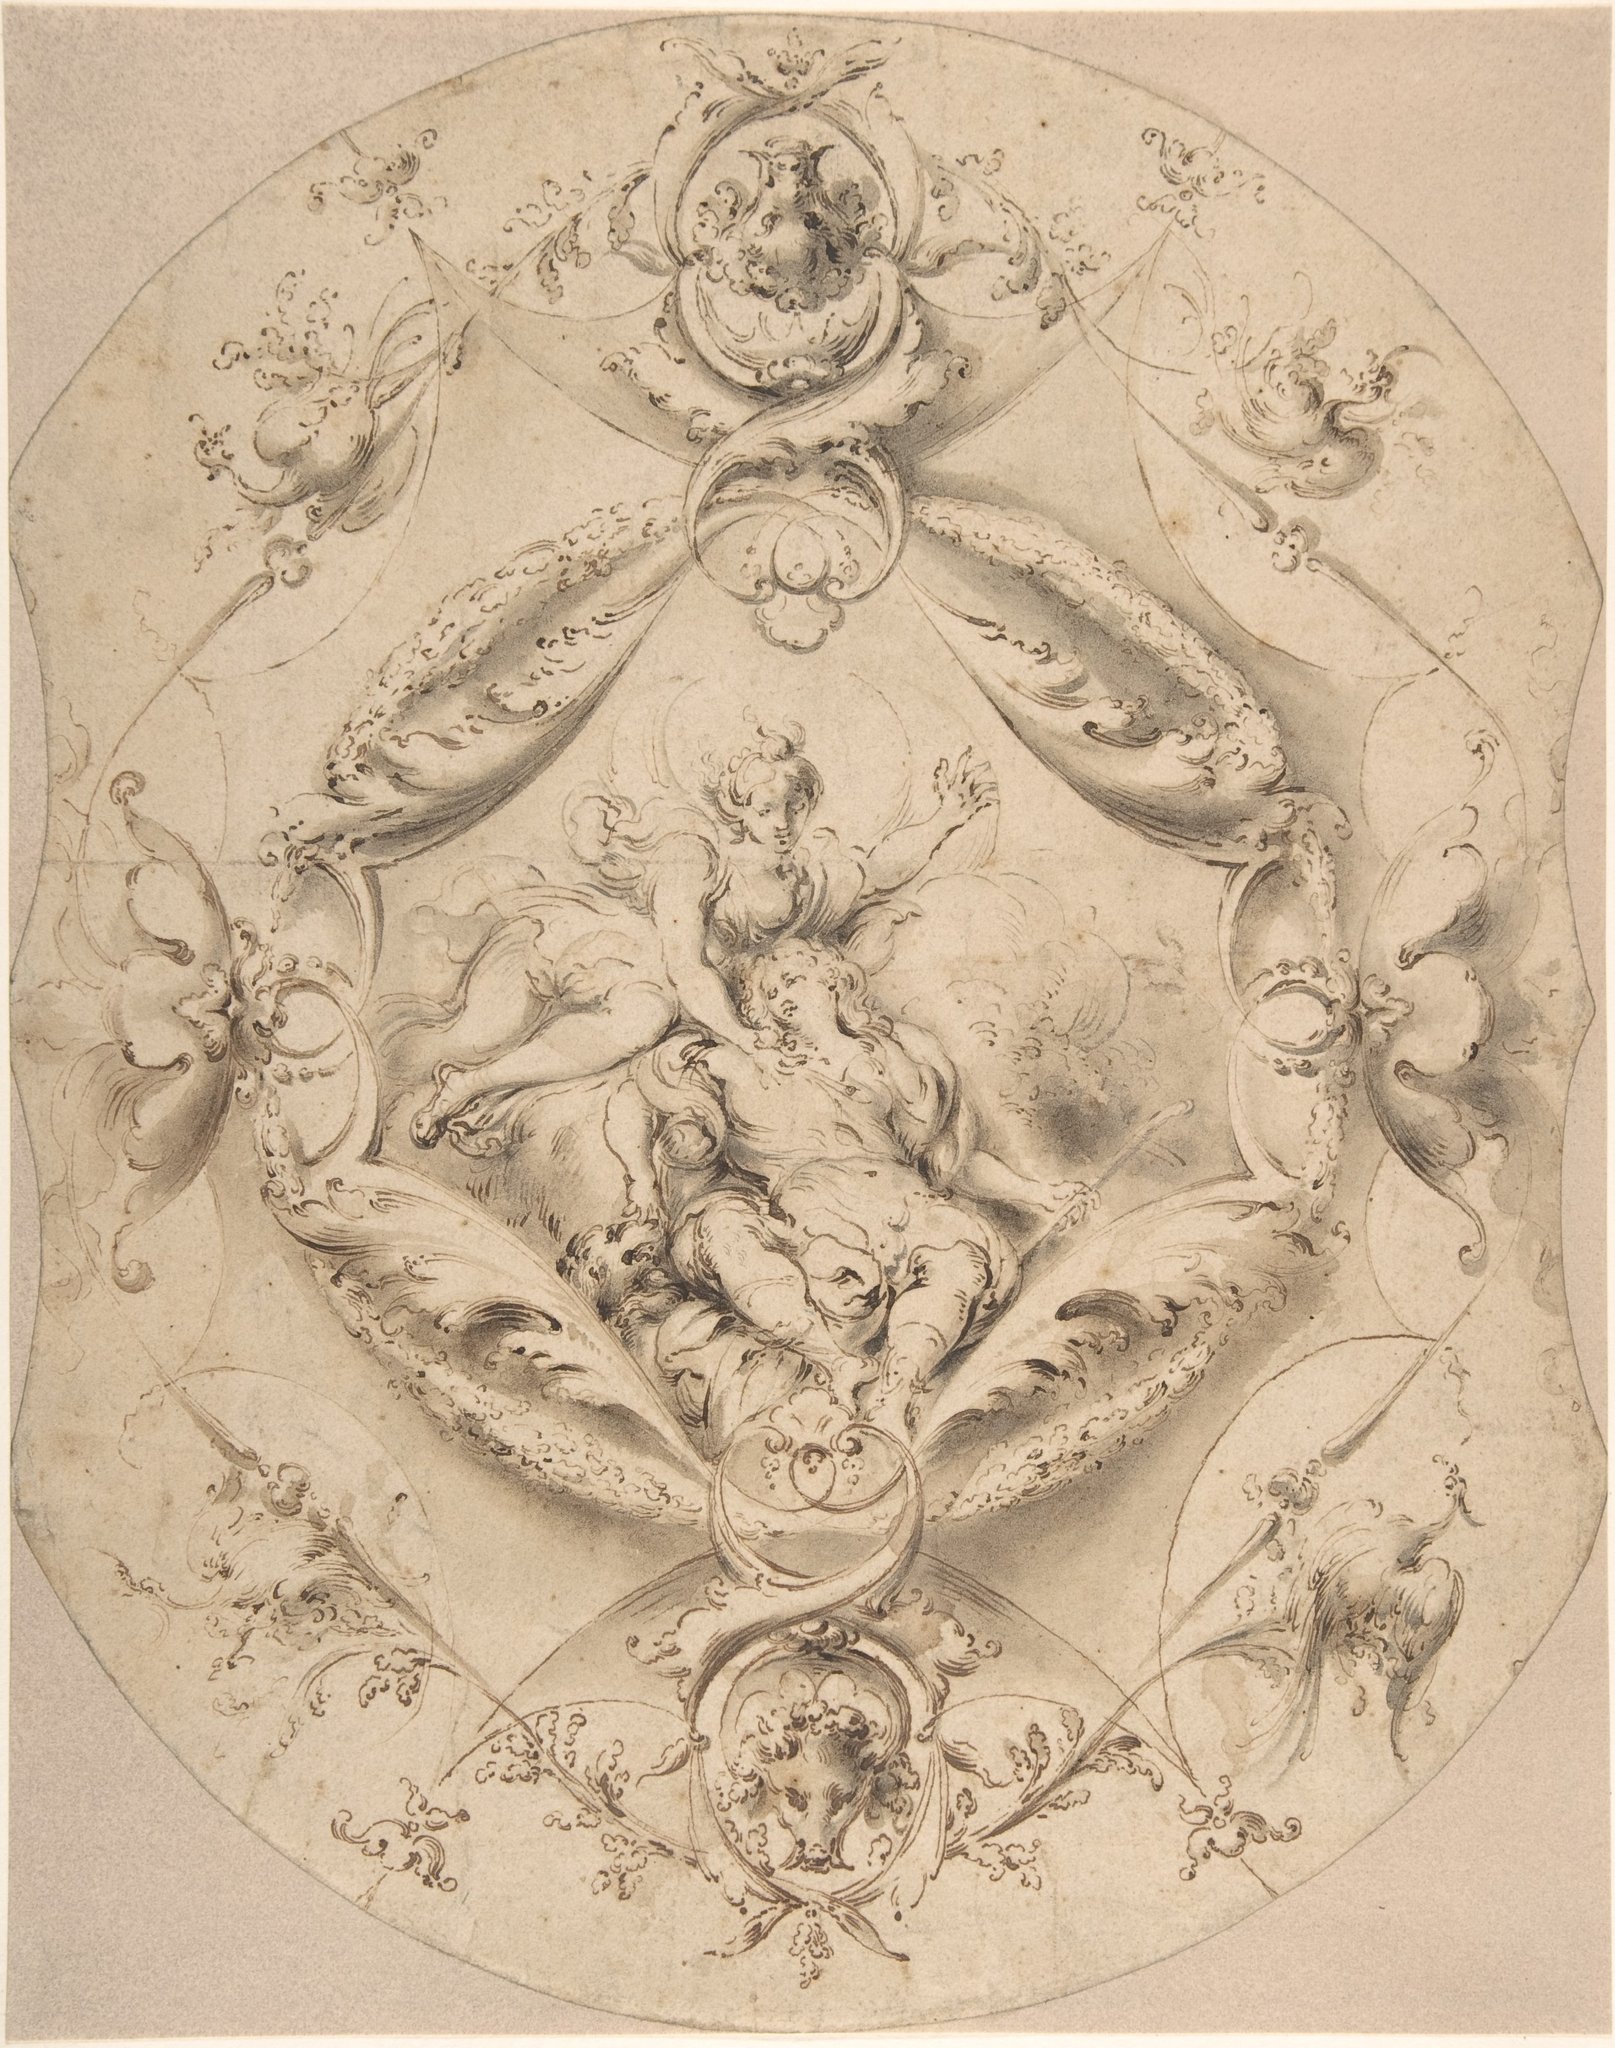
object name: drawing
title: Ornamental Design with Diana and Endymion in a Central Cartouche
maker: jacob denys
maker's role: artist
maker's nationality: flemish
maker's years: 1644-1708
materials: gold, ink, paper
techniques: brush, pen, wash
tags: cartouches,ornament,diana